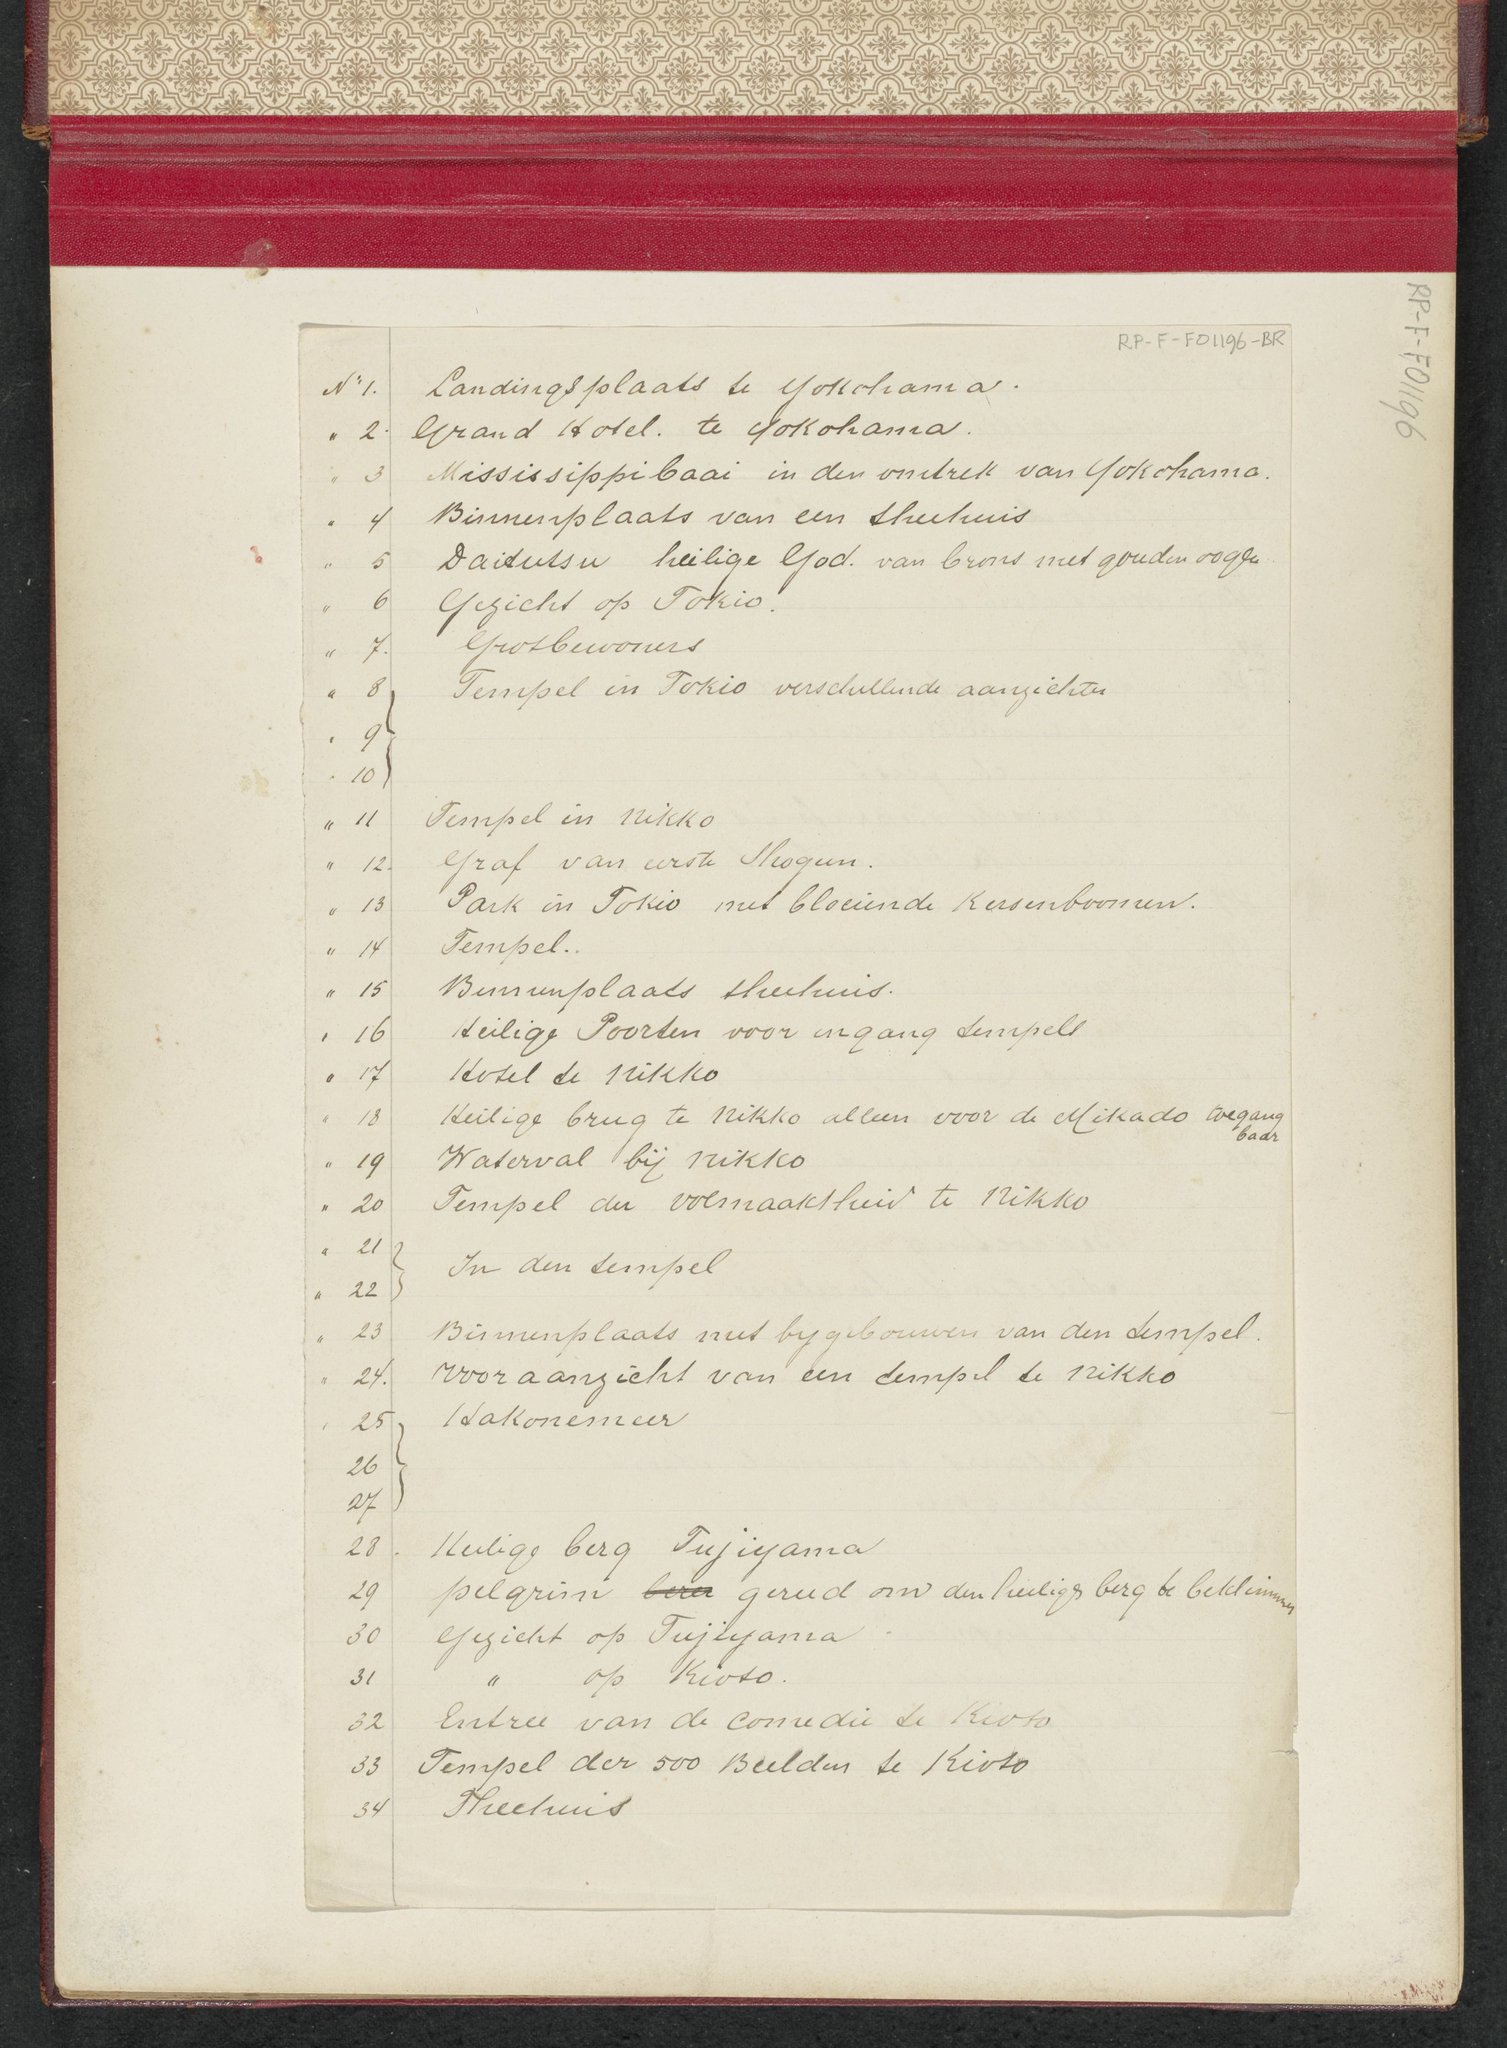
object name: list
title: Lijst met in het album afgebeelde onderwerpen (1 t/m 34)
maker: Anonymous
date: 1890-1894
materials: paper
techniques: writing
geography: netherlands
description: Onderdeel van Album met 69 foto's van een reis door Japan.